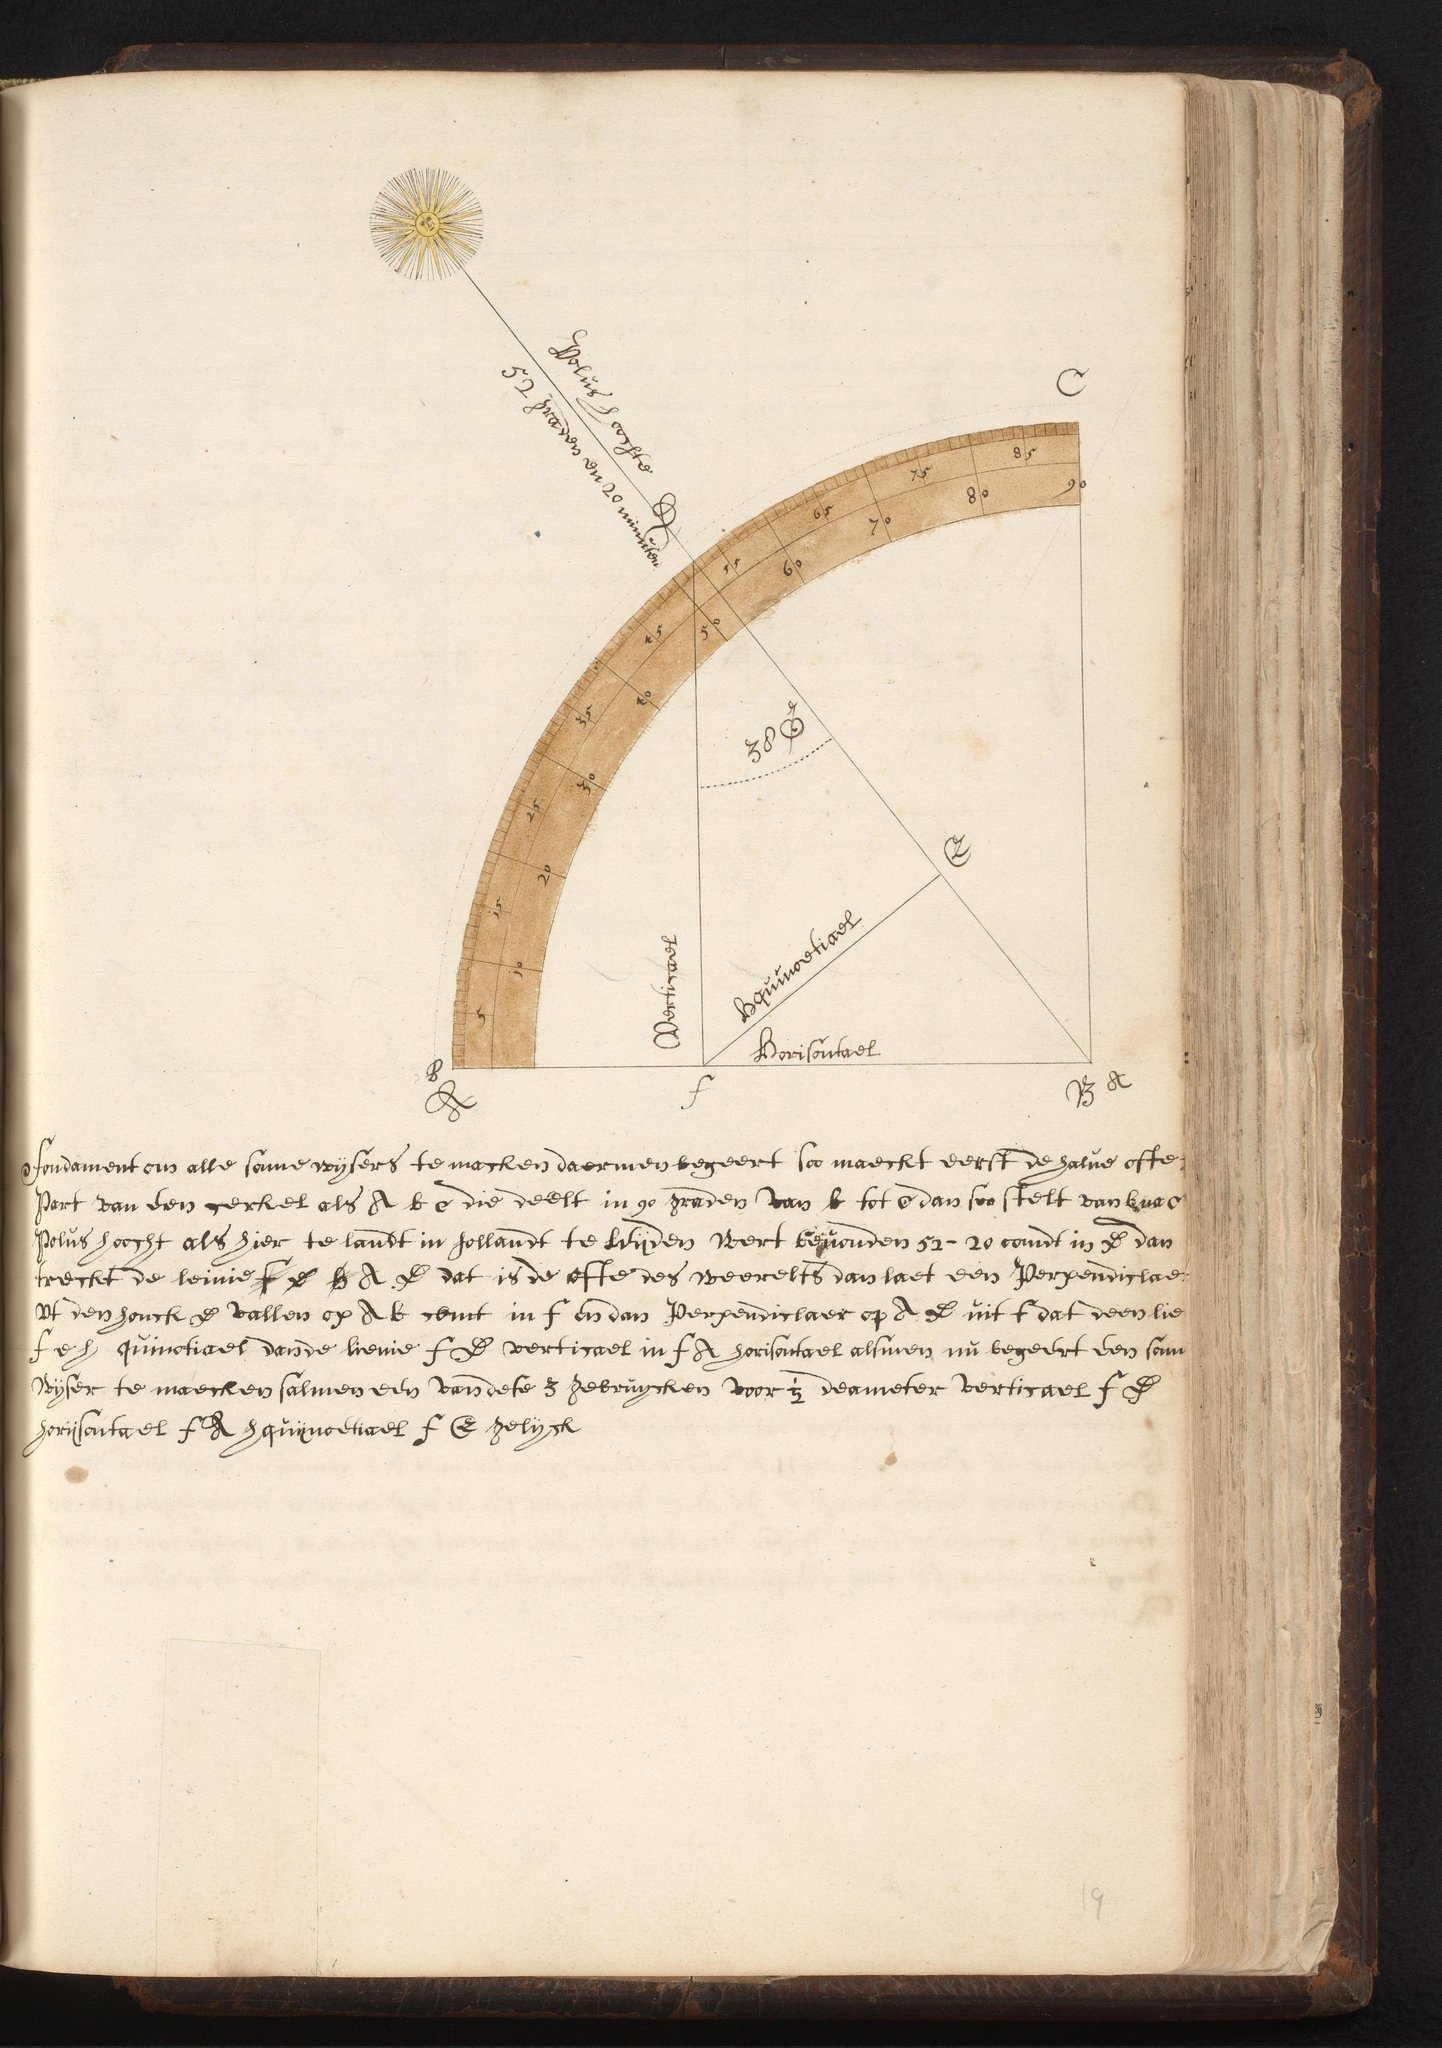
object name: album leaf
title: Fondament om alle sonnewijzers te macken daer men begeert (...)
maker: Anonymous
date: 1650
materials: ink, paper, pencil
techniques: brush, pen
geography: low countries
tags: measuring, sundial